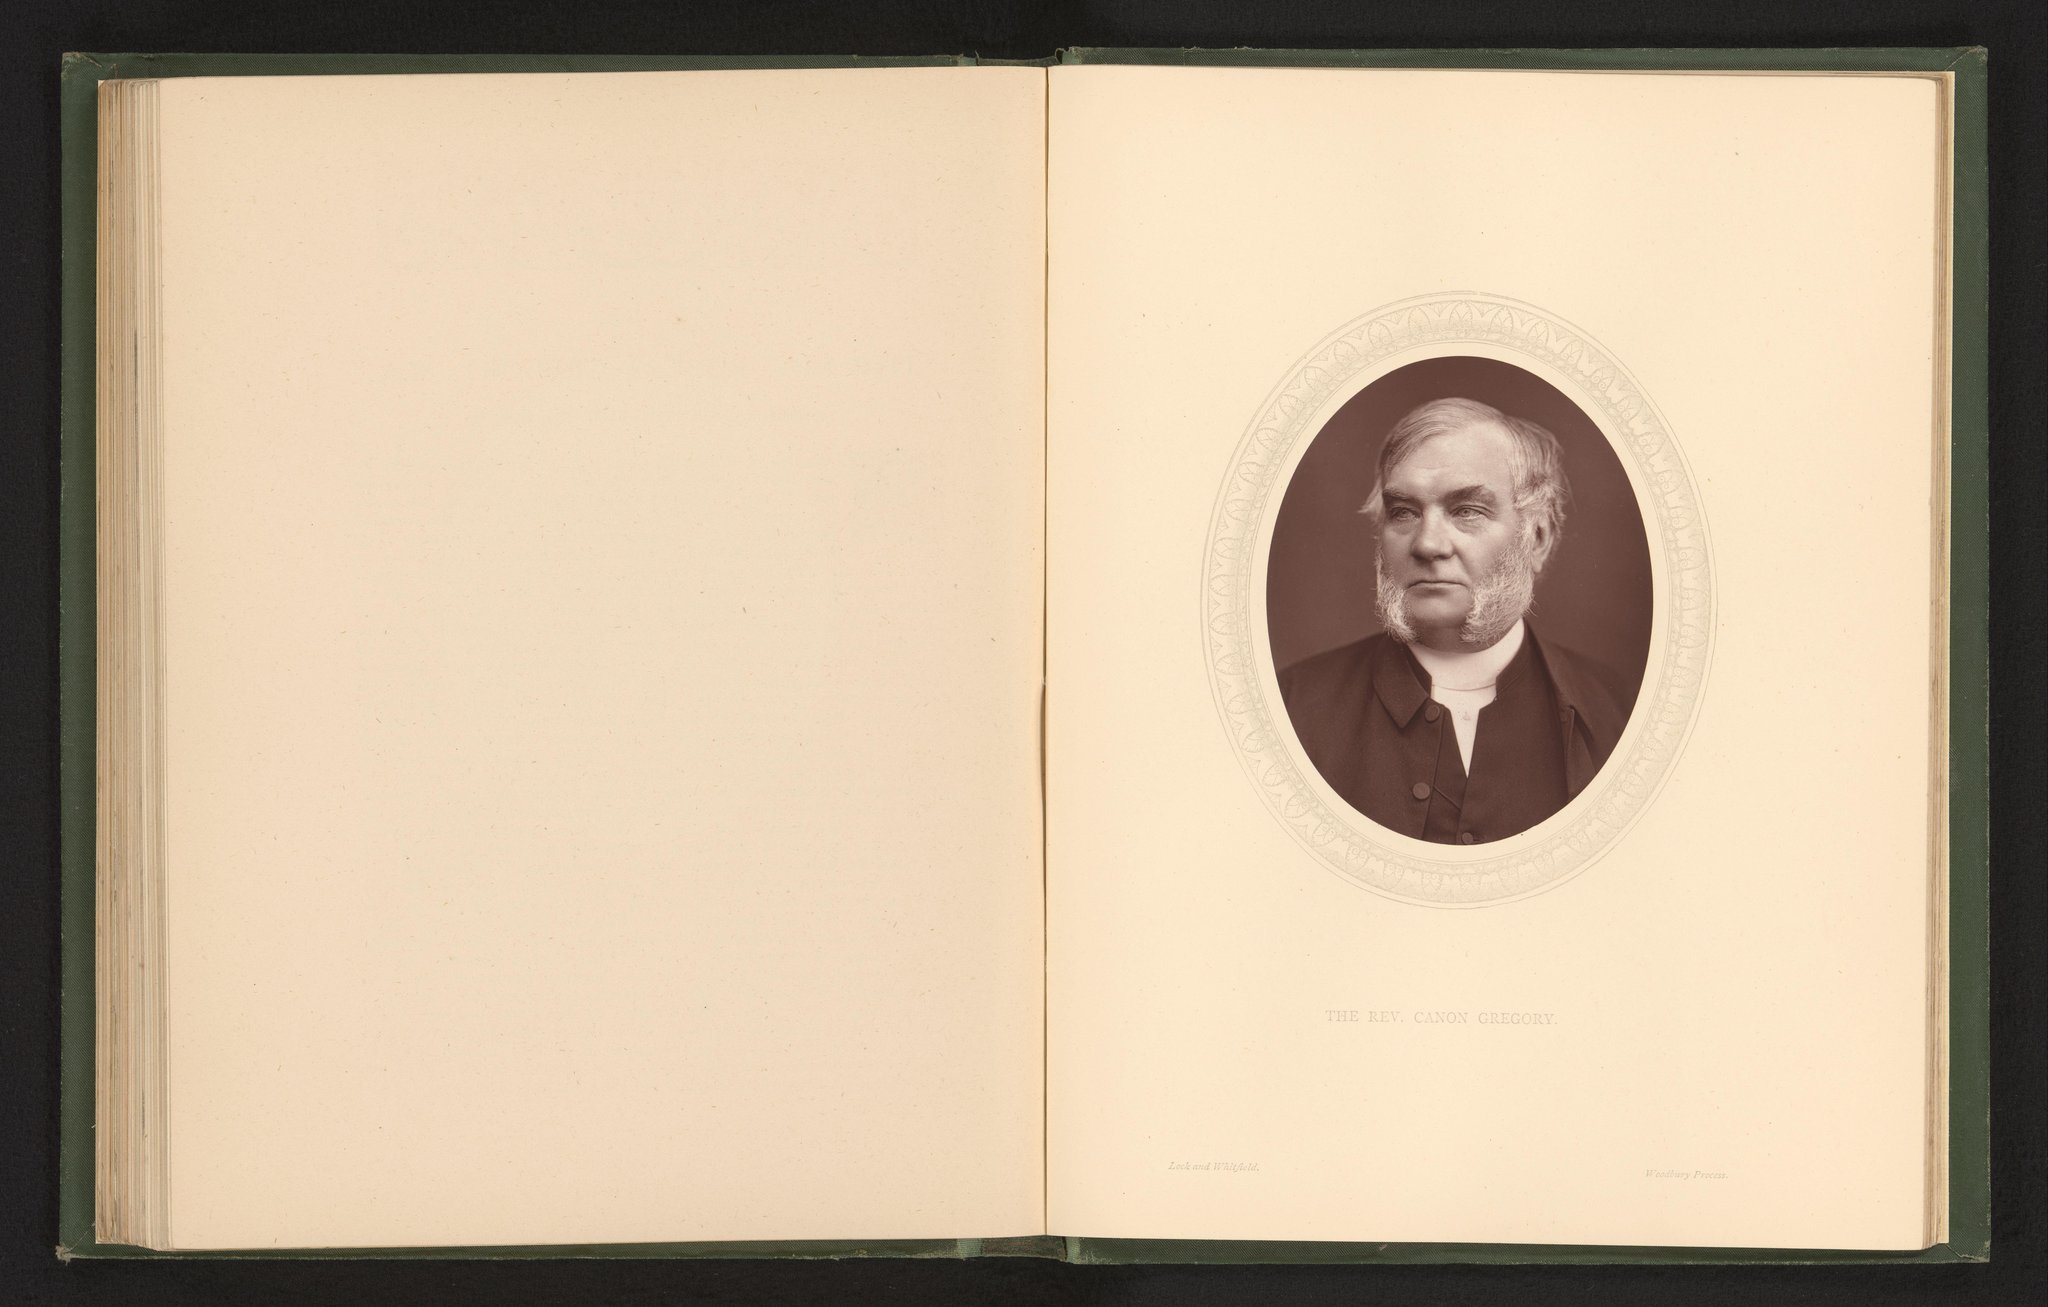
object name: page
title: The rev. Canon Gregory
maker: Anonymous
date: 1872-1877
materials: paper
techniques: woodburytype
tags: priest, priest (roman catholic), historical persons (portraits and scenes from the life) (+ (full) bust portrait)